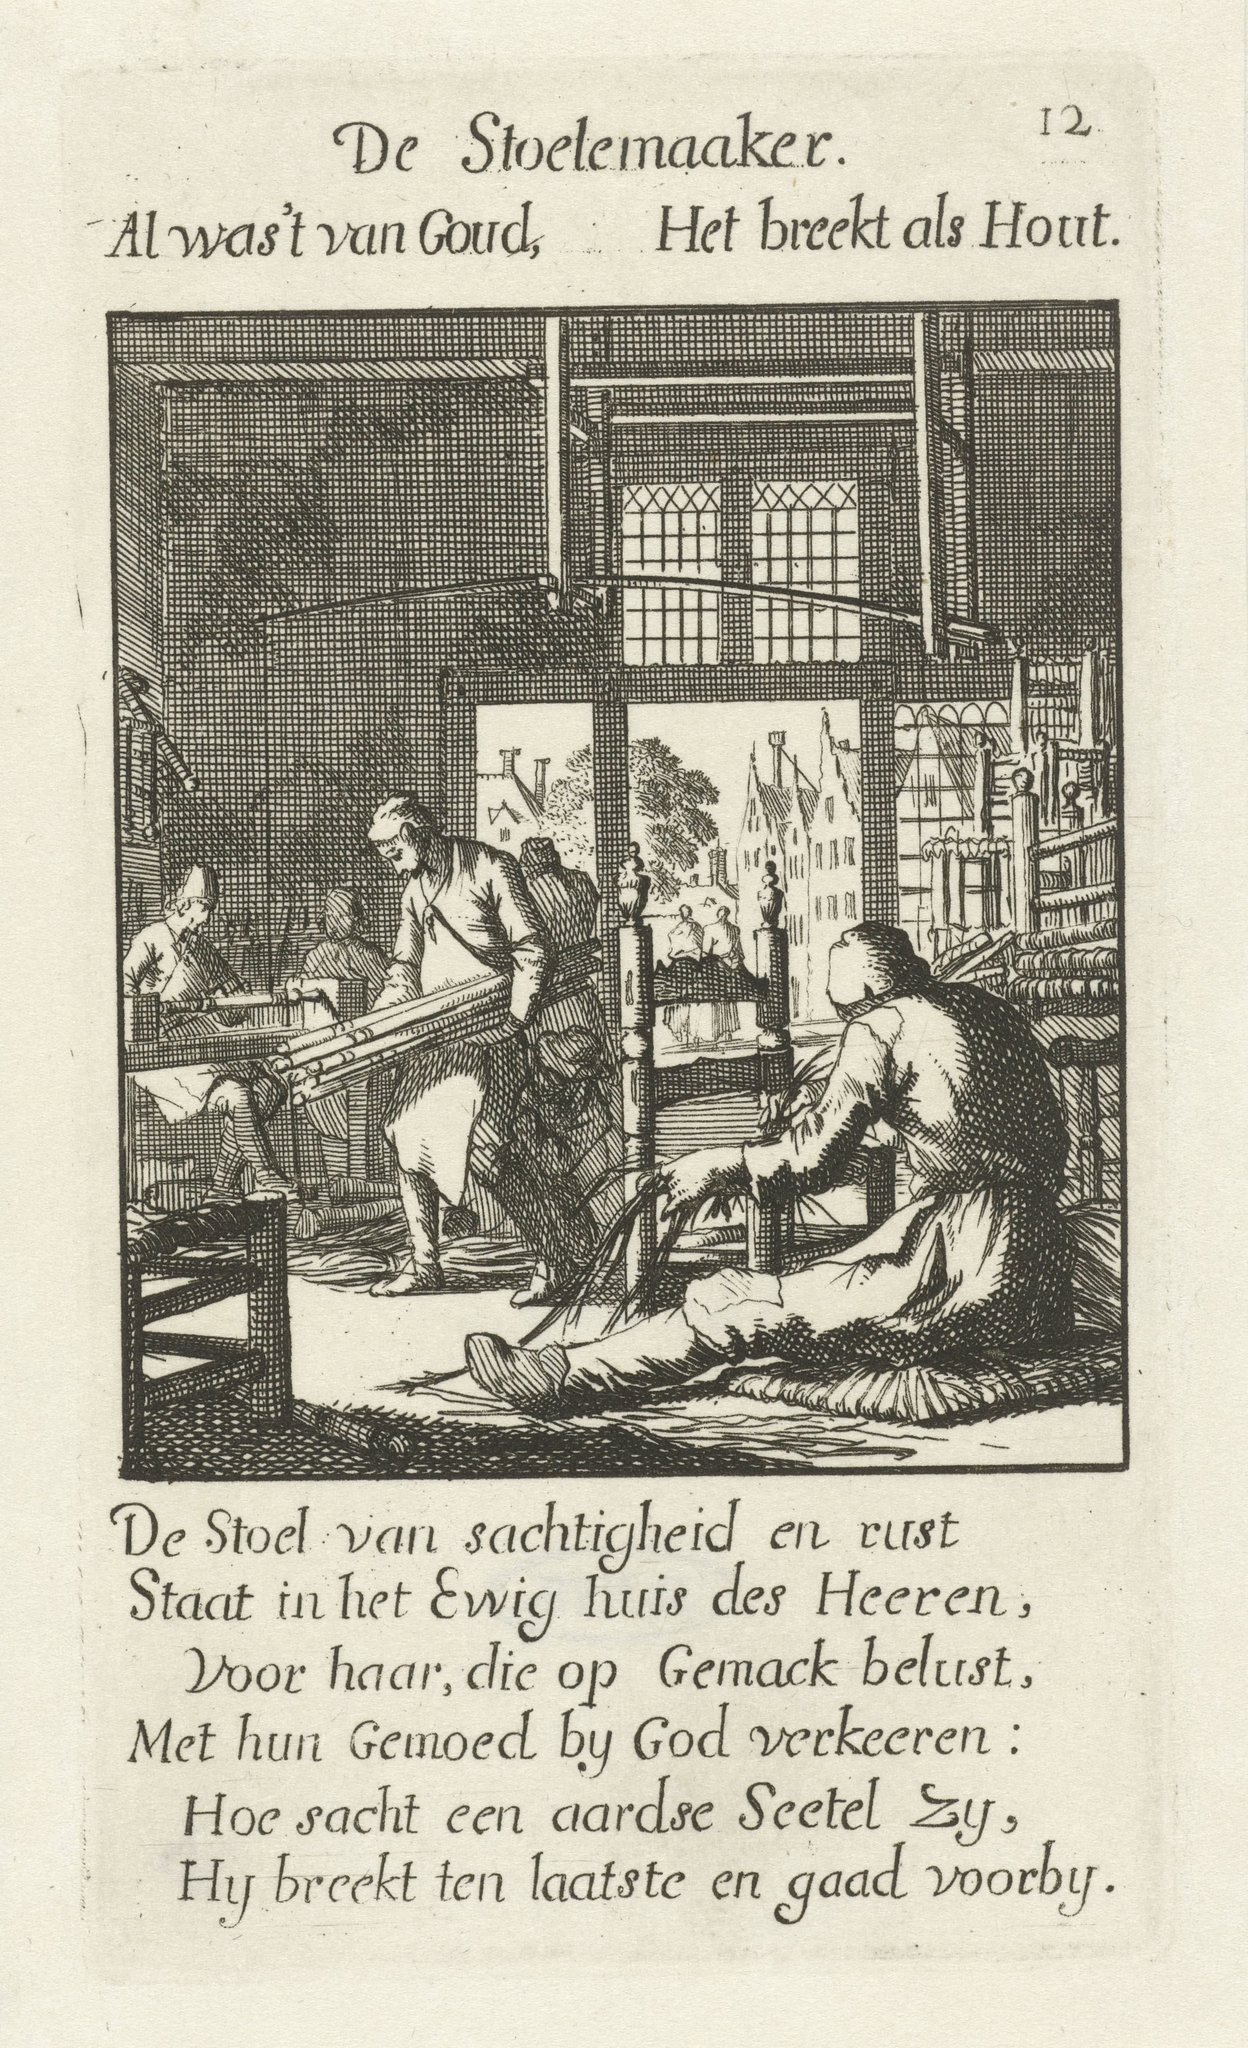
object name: print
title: Het Menselyk Bedryf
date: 1694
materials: paper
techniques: etching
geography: amsterdam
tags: handicrafts, craftsman at work, chair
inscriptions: collector's mark: Lugt 2760, collector's mark: Lugt 2228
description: Maakt deel uit van de 100-delige serie beroepsprenten van Jan en Caspar Luyken, getiteld: Het menselyk bedryf. S.l.s.n., 1694 (eerste druk).